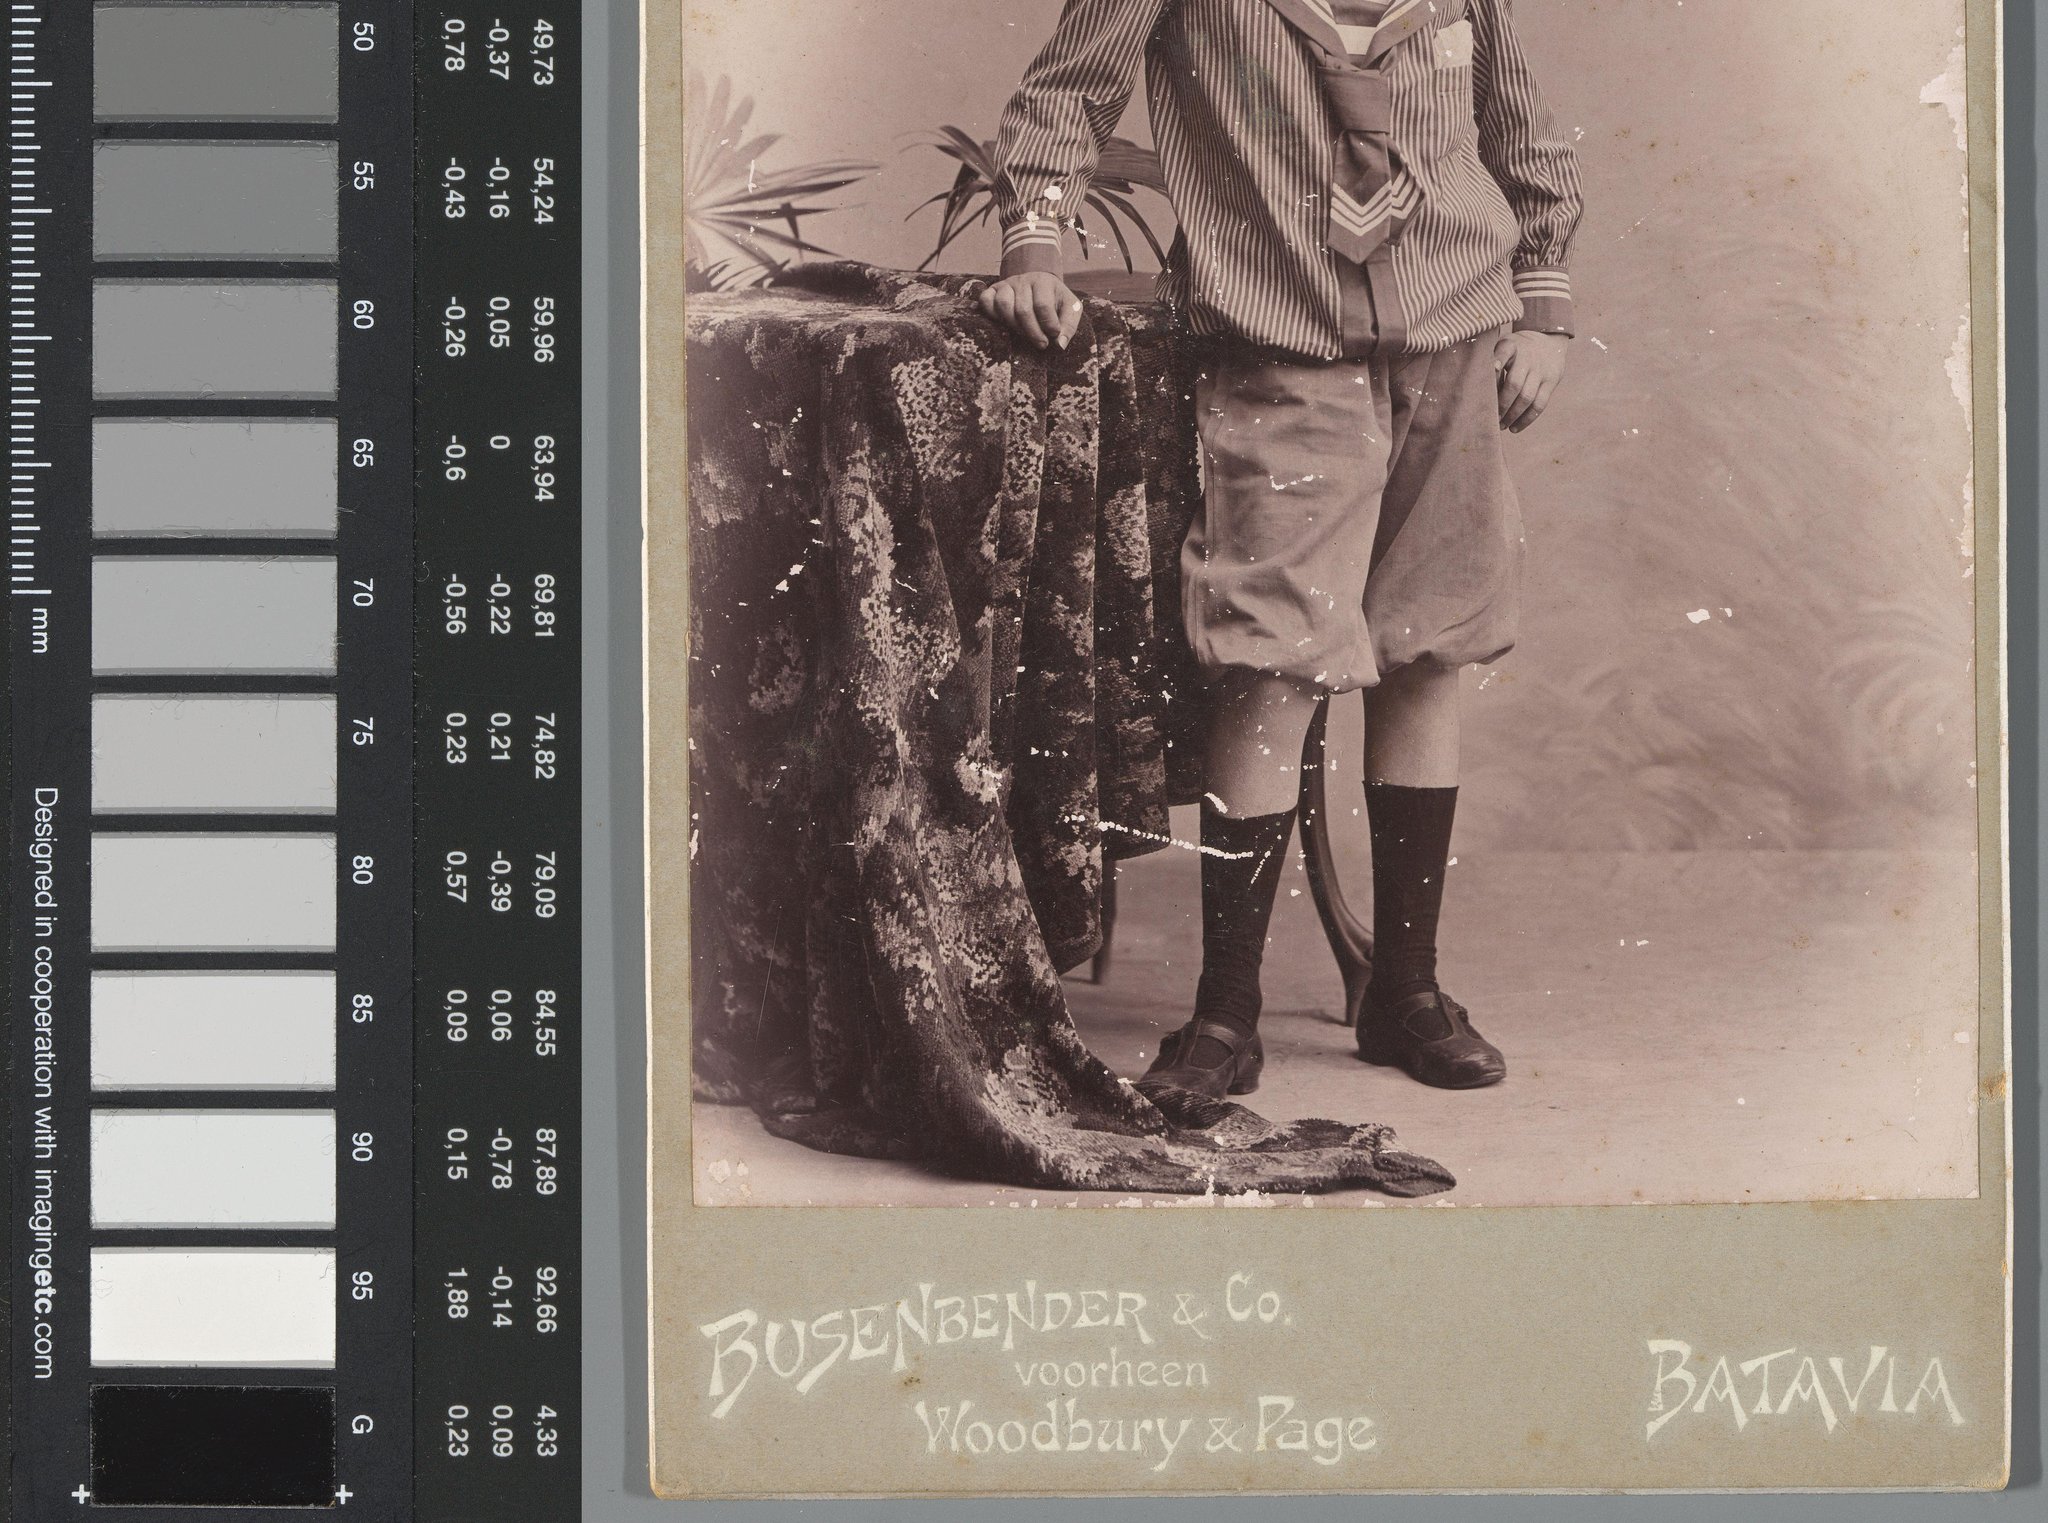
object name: cabinet photograph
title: Studioportret van de zoon van Piet Onnen en Emilie van den Berg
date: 1900-1910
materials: cardboard, photographic support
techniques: albumen print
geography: batavia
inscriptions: name: ‘Photographie / Busenbender & Co / voorheen / Woodbury & Page. / BATAVIA.’, name: ‘BUSENBENDER & Co. voorheen / Woodbury & Page / BATAVIA’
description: Staande jongen met kort haar leunend op een tafel.